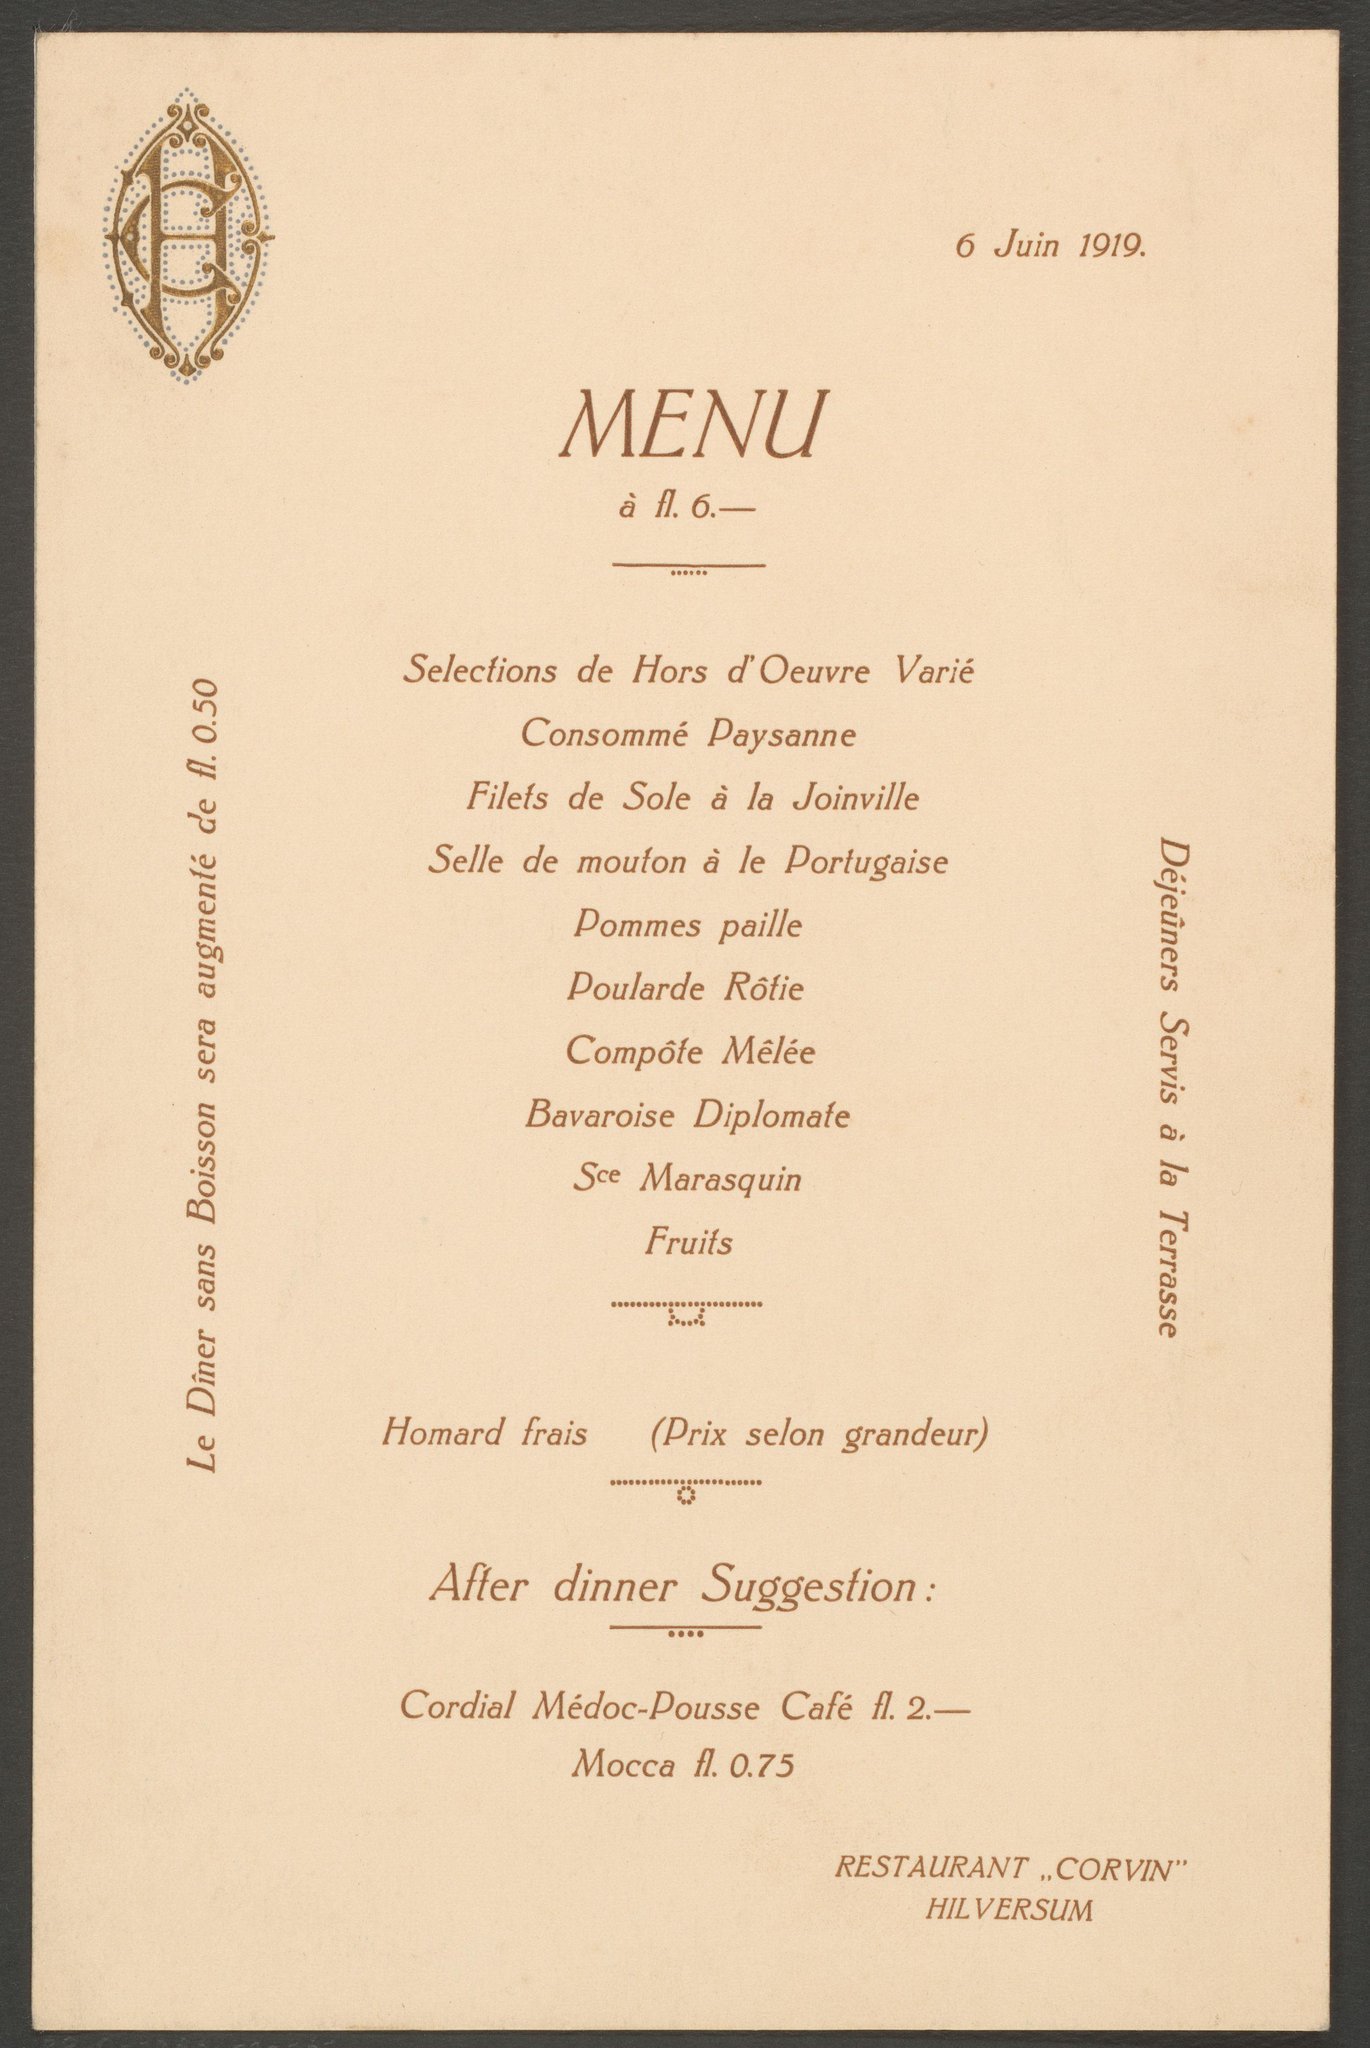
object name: menu, menukaart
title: Menukaart van hotel-restaurant Corvin te Hilversum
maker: reinier willem petrus de vries (1874-1953)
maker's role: draughtsman, print maker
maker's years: 1874-1953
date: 1919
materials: paper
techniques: relief print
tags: magic mathematical figures; magic numbers, words, monograms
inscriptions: collector's mark: ‘R:MVS.’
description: Monogram met de letters H en C in een ovaal.